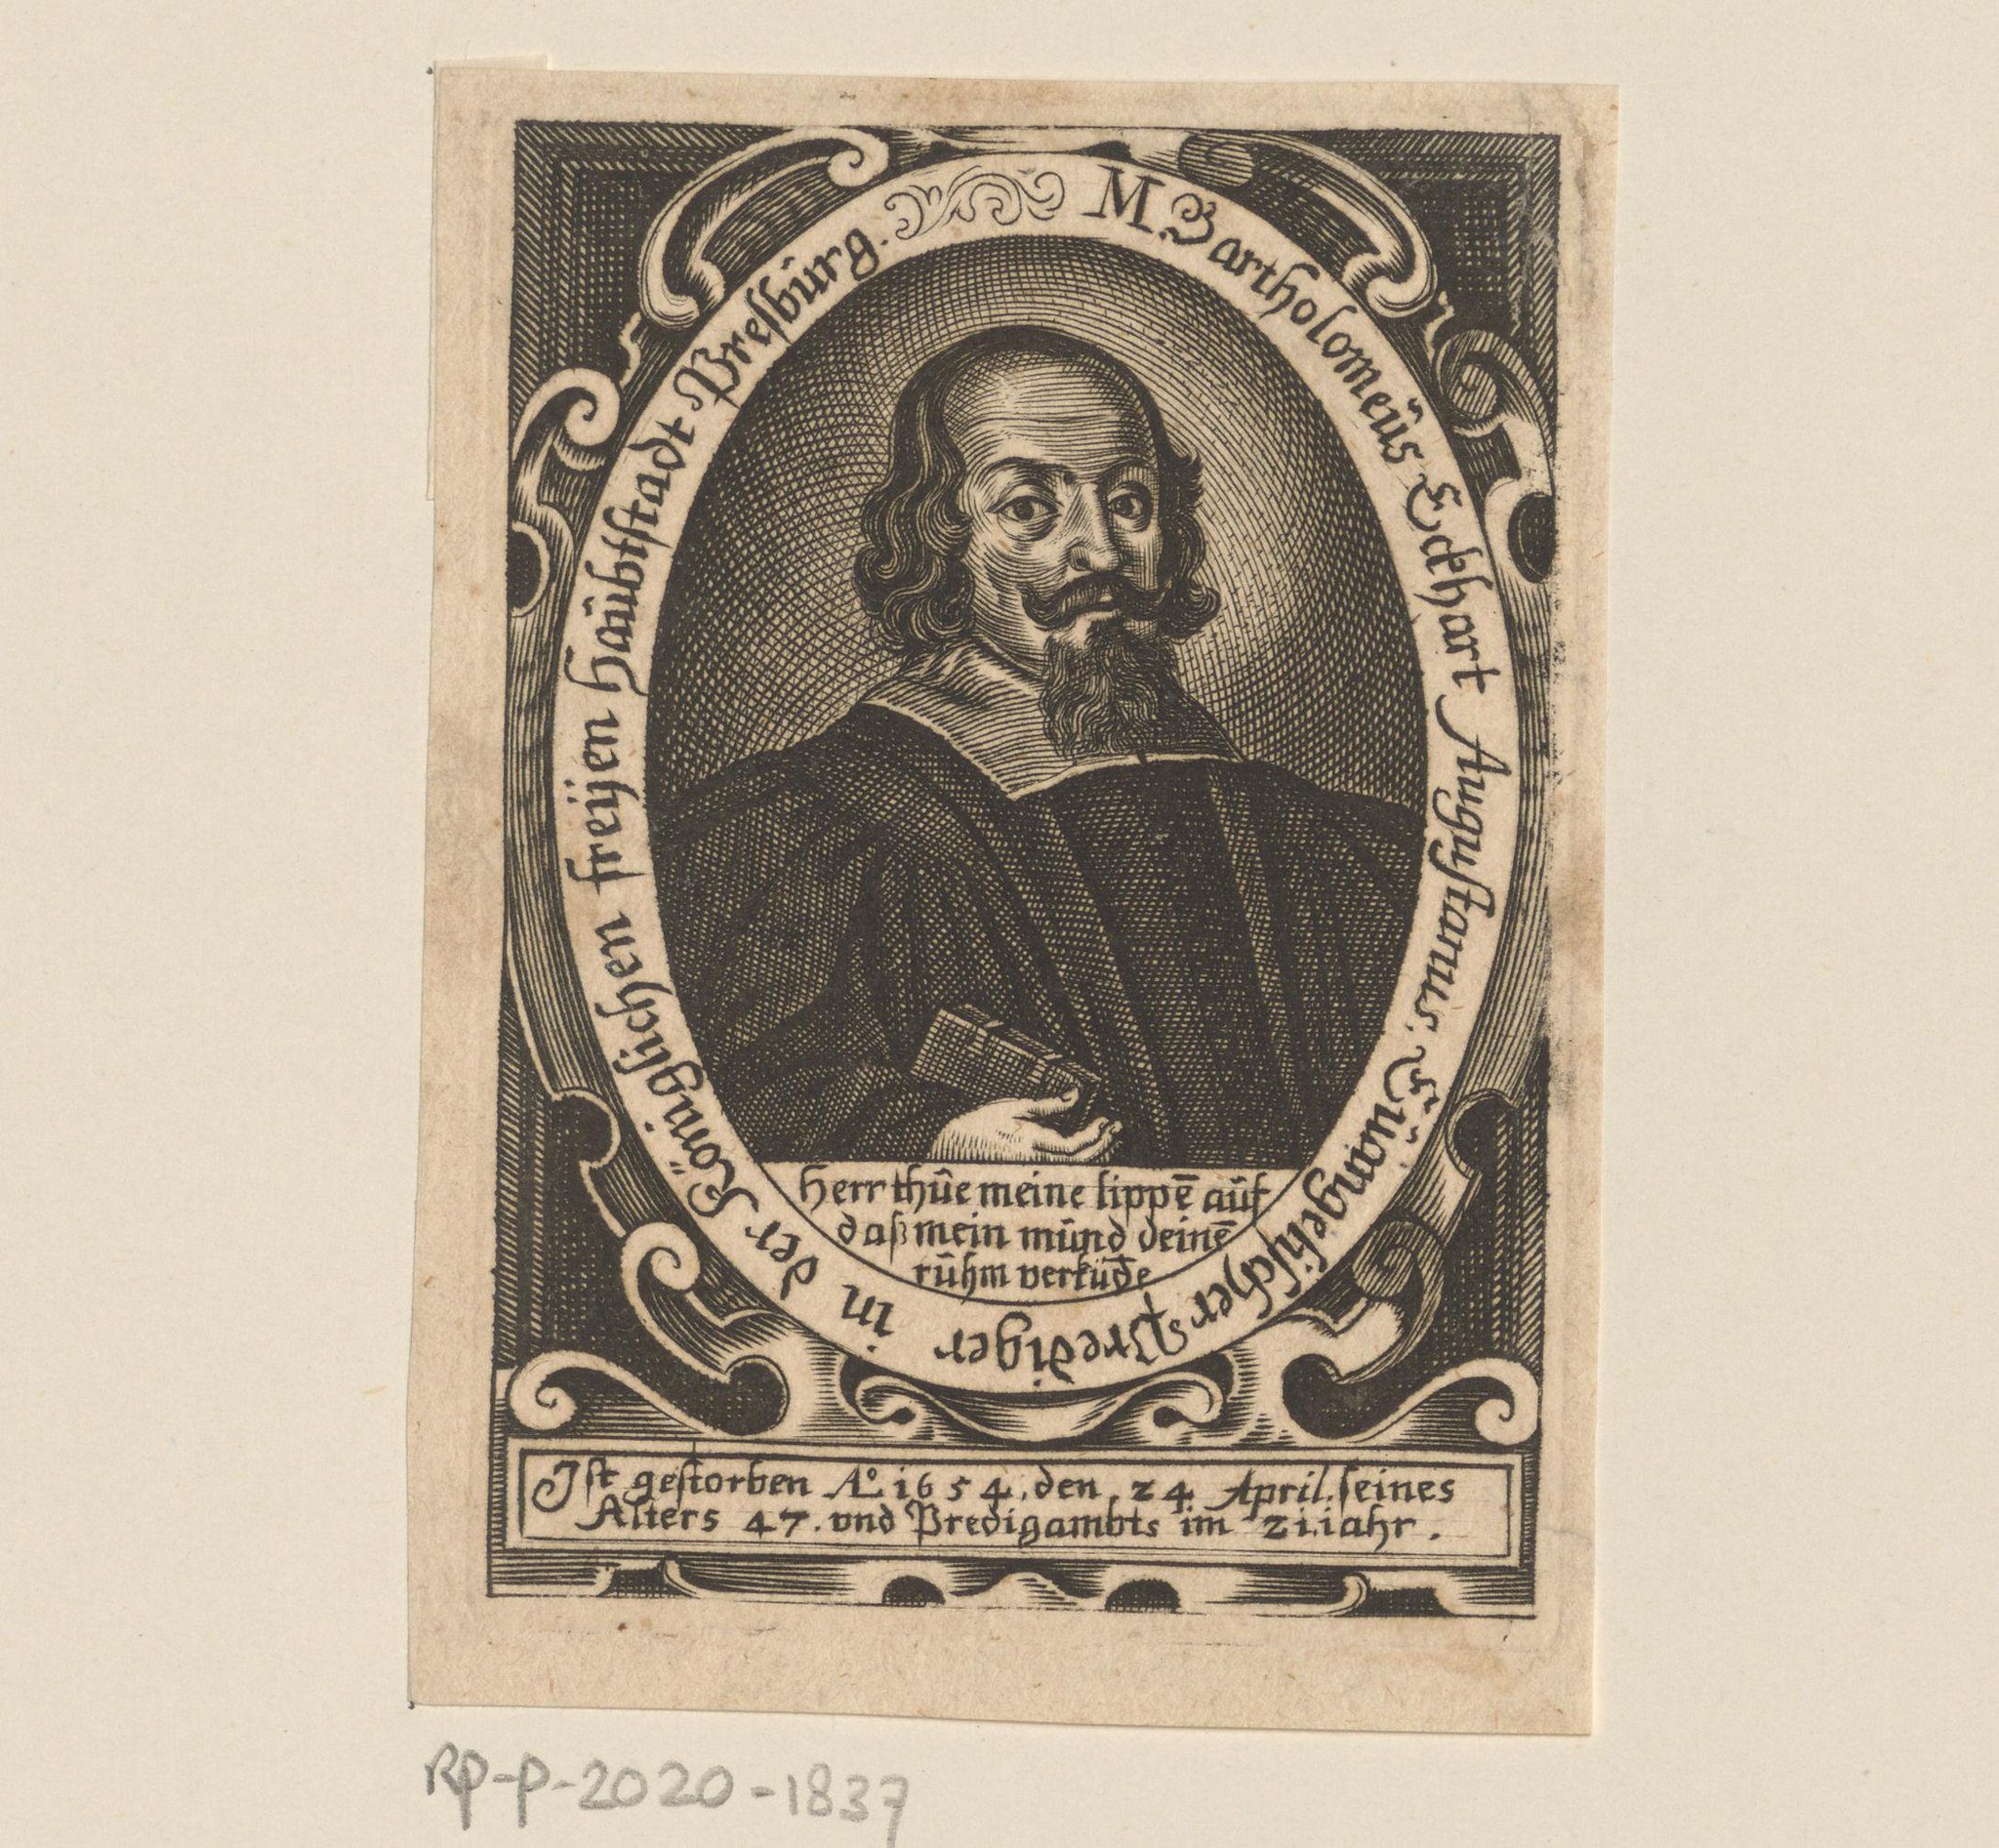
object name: print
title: Portret van Bartholomeus Eckhart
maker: Anonymous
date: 1654-1670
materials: paper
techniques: engraving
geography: germany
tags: historical persons